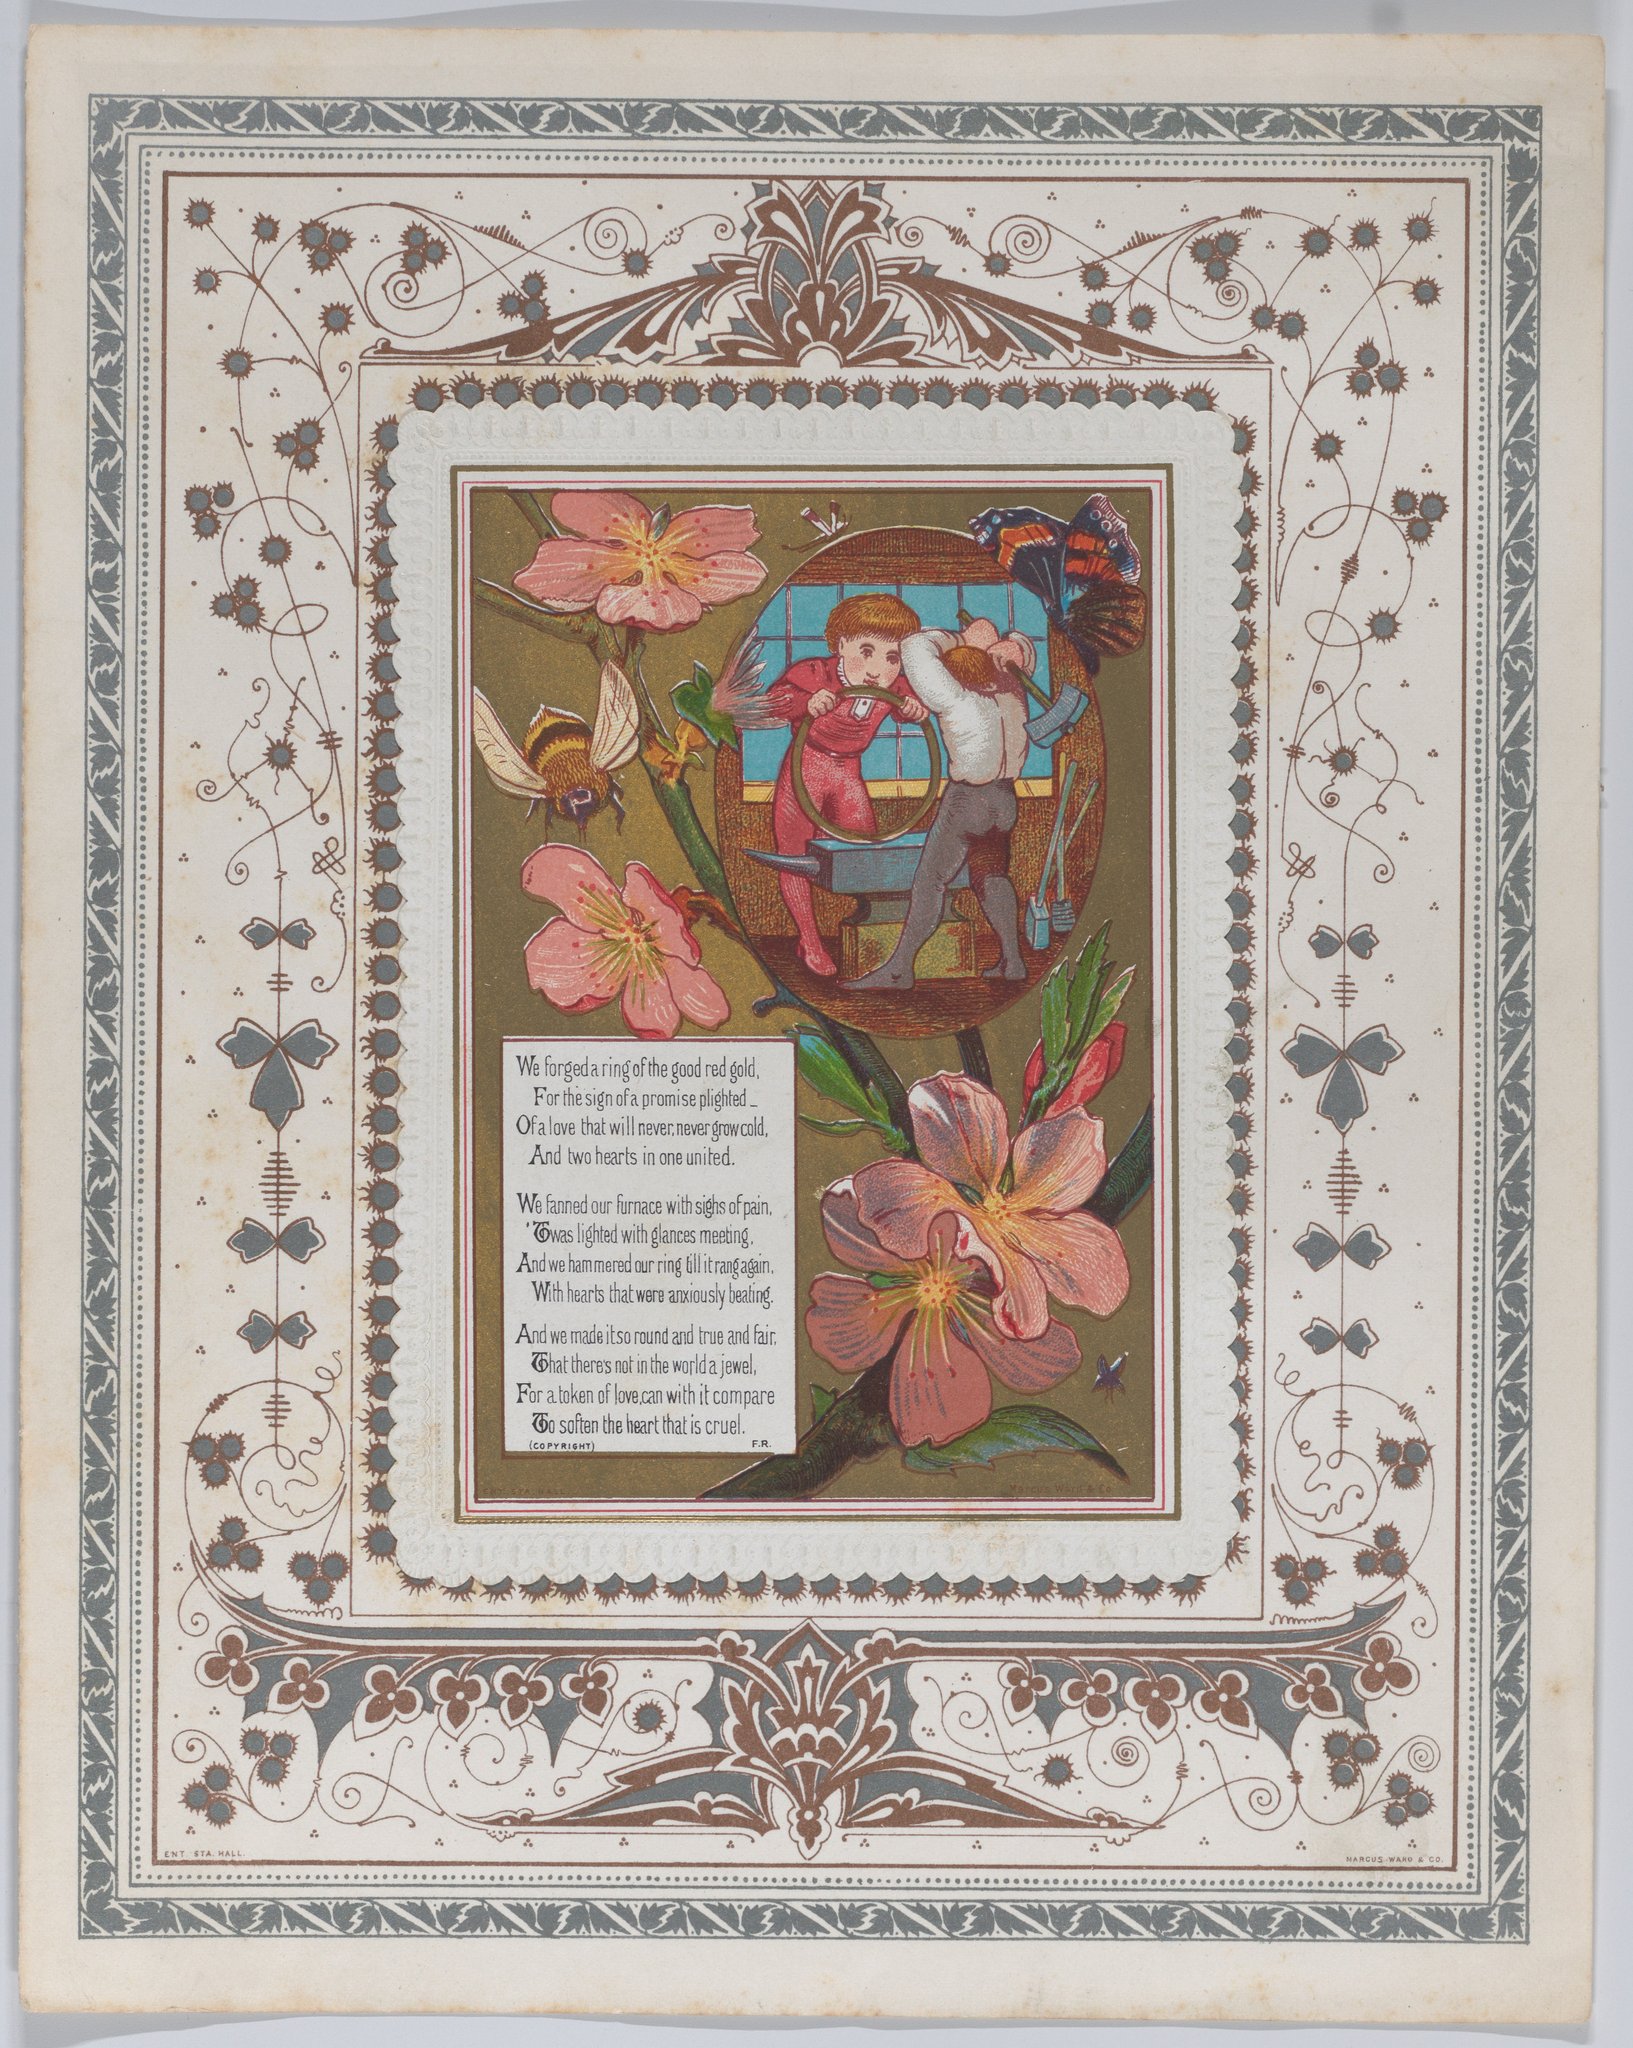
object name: valentine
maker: kate greenaway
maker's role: artist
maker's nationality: british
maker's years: 1846-1901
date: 1874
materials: gold, paper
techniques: chromolithography, embossing, lithograph, silvered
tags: boys,flowers,hammers